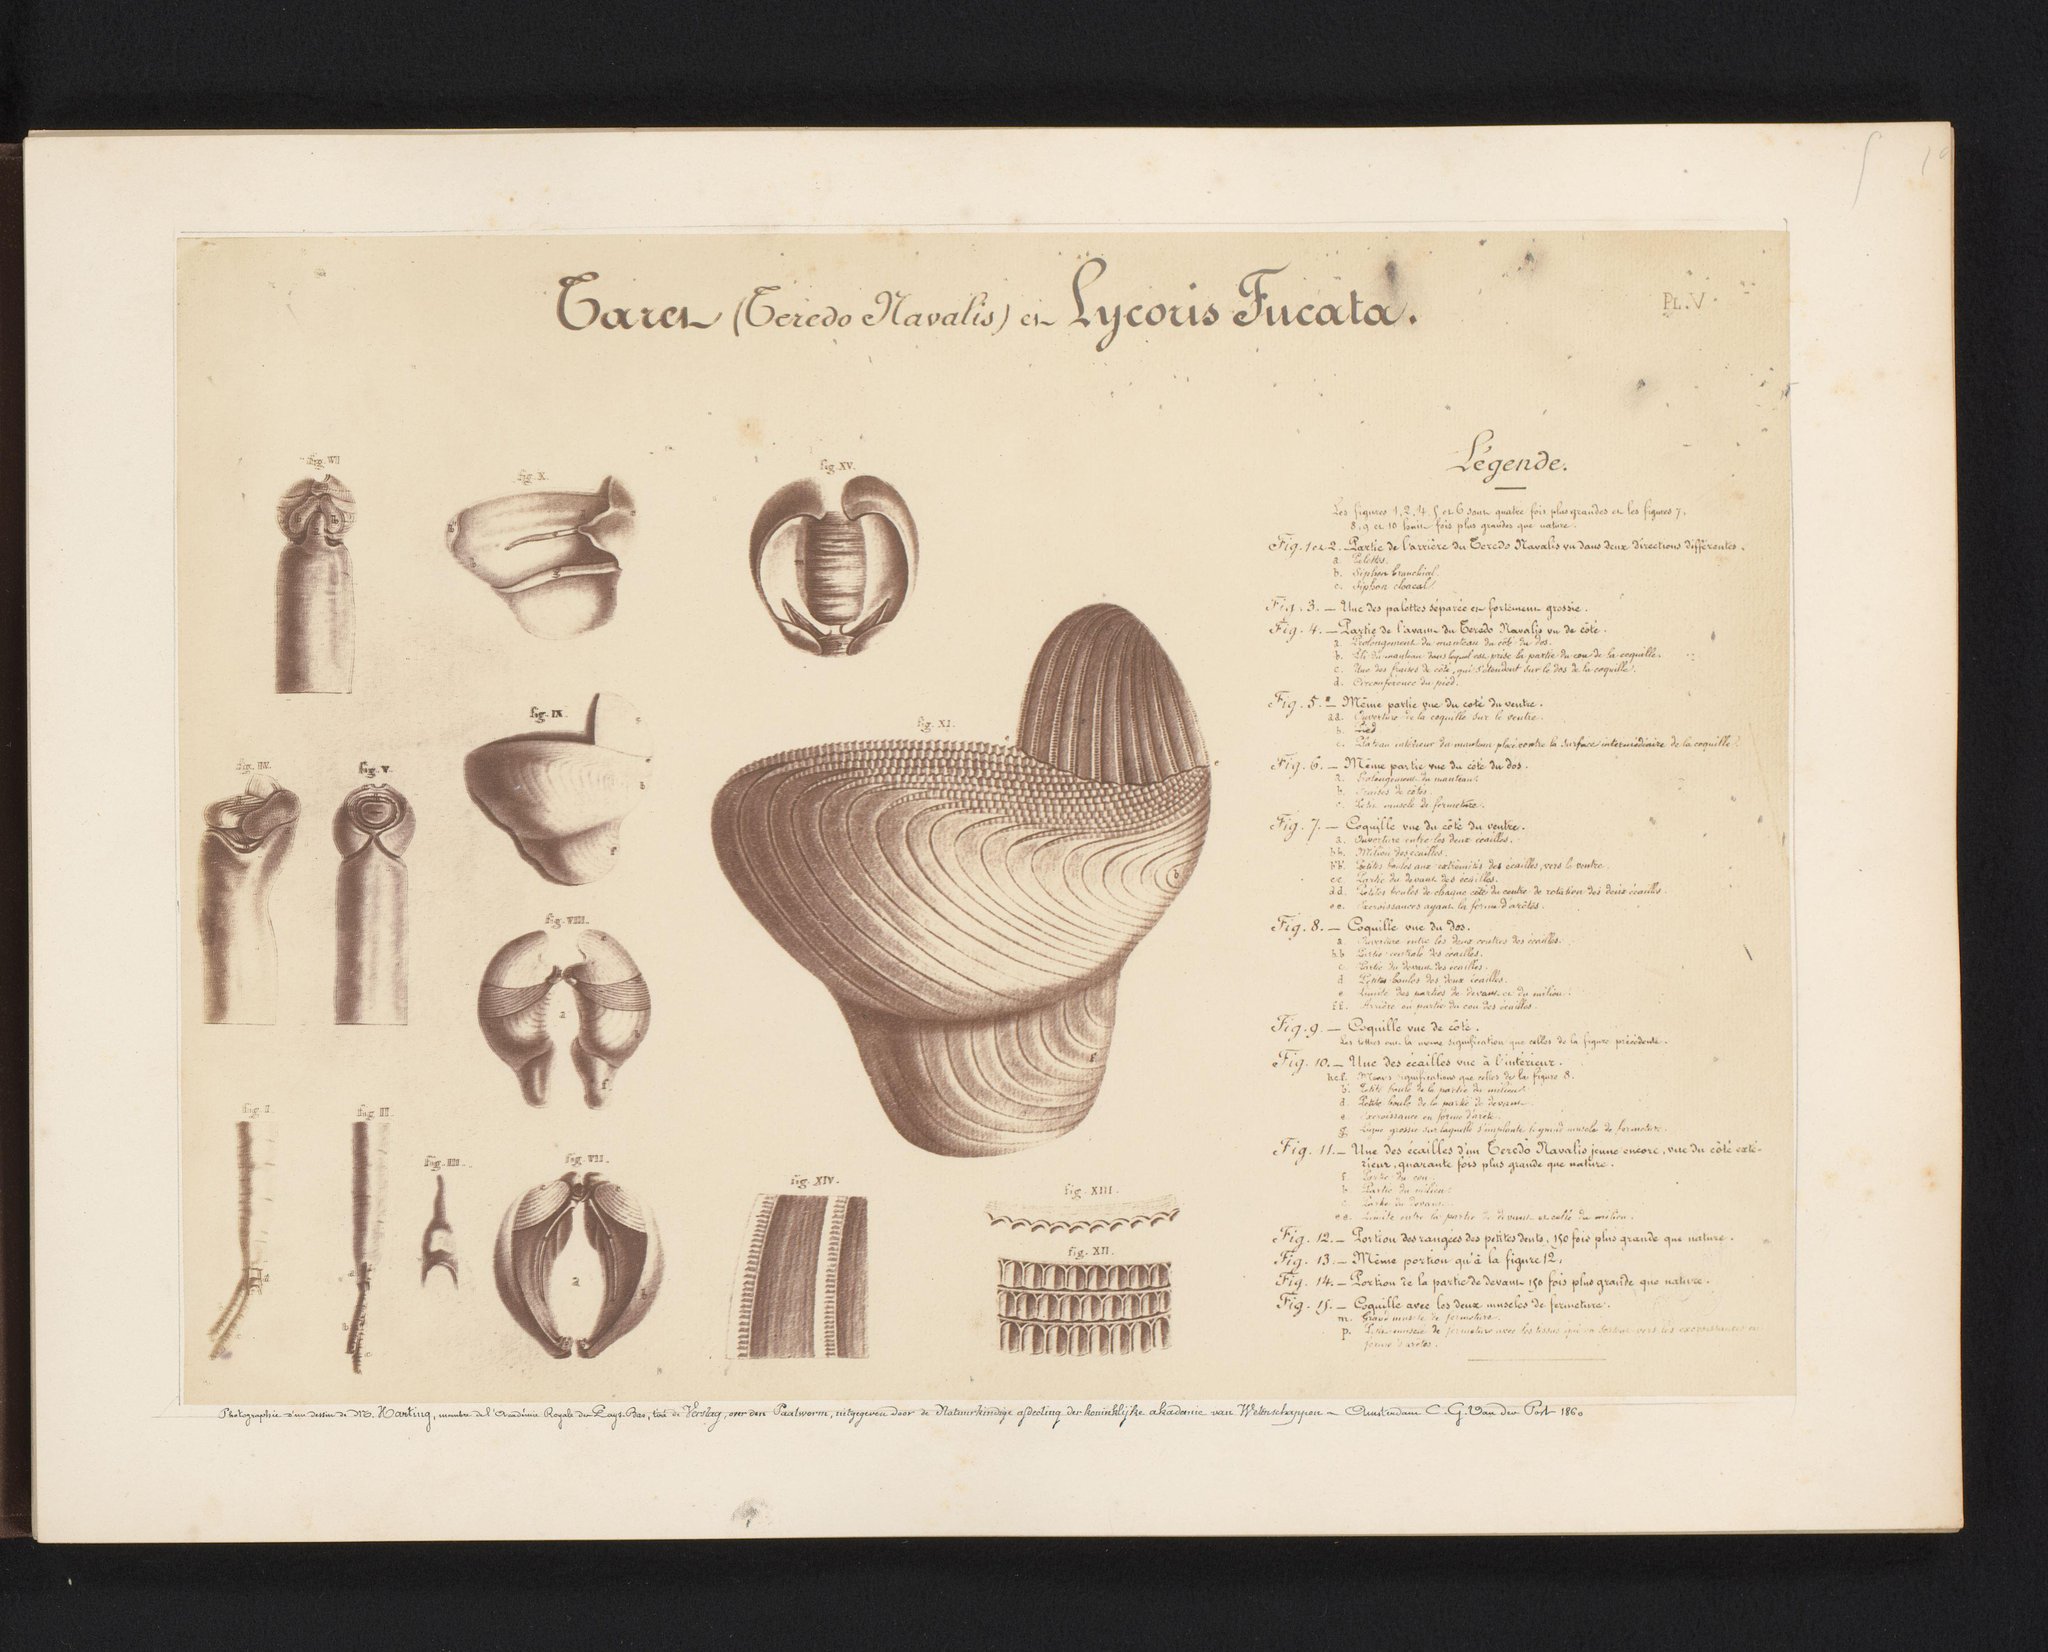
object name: photograph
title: Fotoreproductie van tekeningen van de wormen Teredo Navalis en Lycoris Fucata door Pieter Harting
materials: cardboard, photographic support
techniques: albumen print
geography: france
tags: worms, drawing, sketch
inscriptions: annotation: ‘Photographie d'un dessin de Mr Harting, Membre de l'Académie Royale des Pays-Bas, tiré de Verslag, over den Paalworm, Uitgegeven door de Natuurkundige afdeling der koninklijke Akademie van Wetenschappen, Amsterdam. C. G. van der Post. 1860.’, signature: ‘B. Crolet’